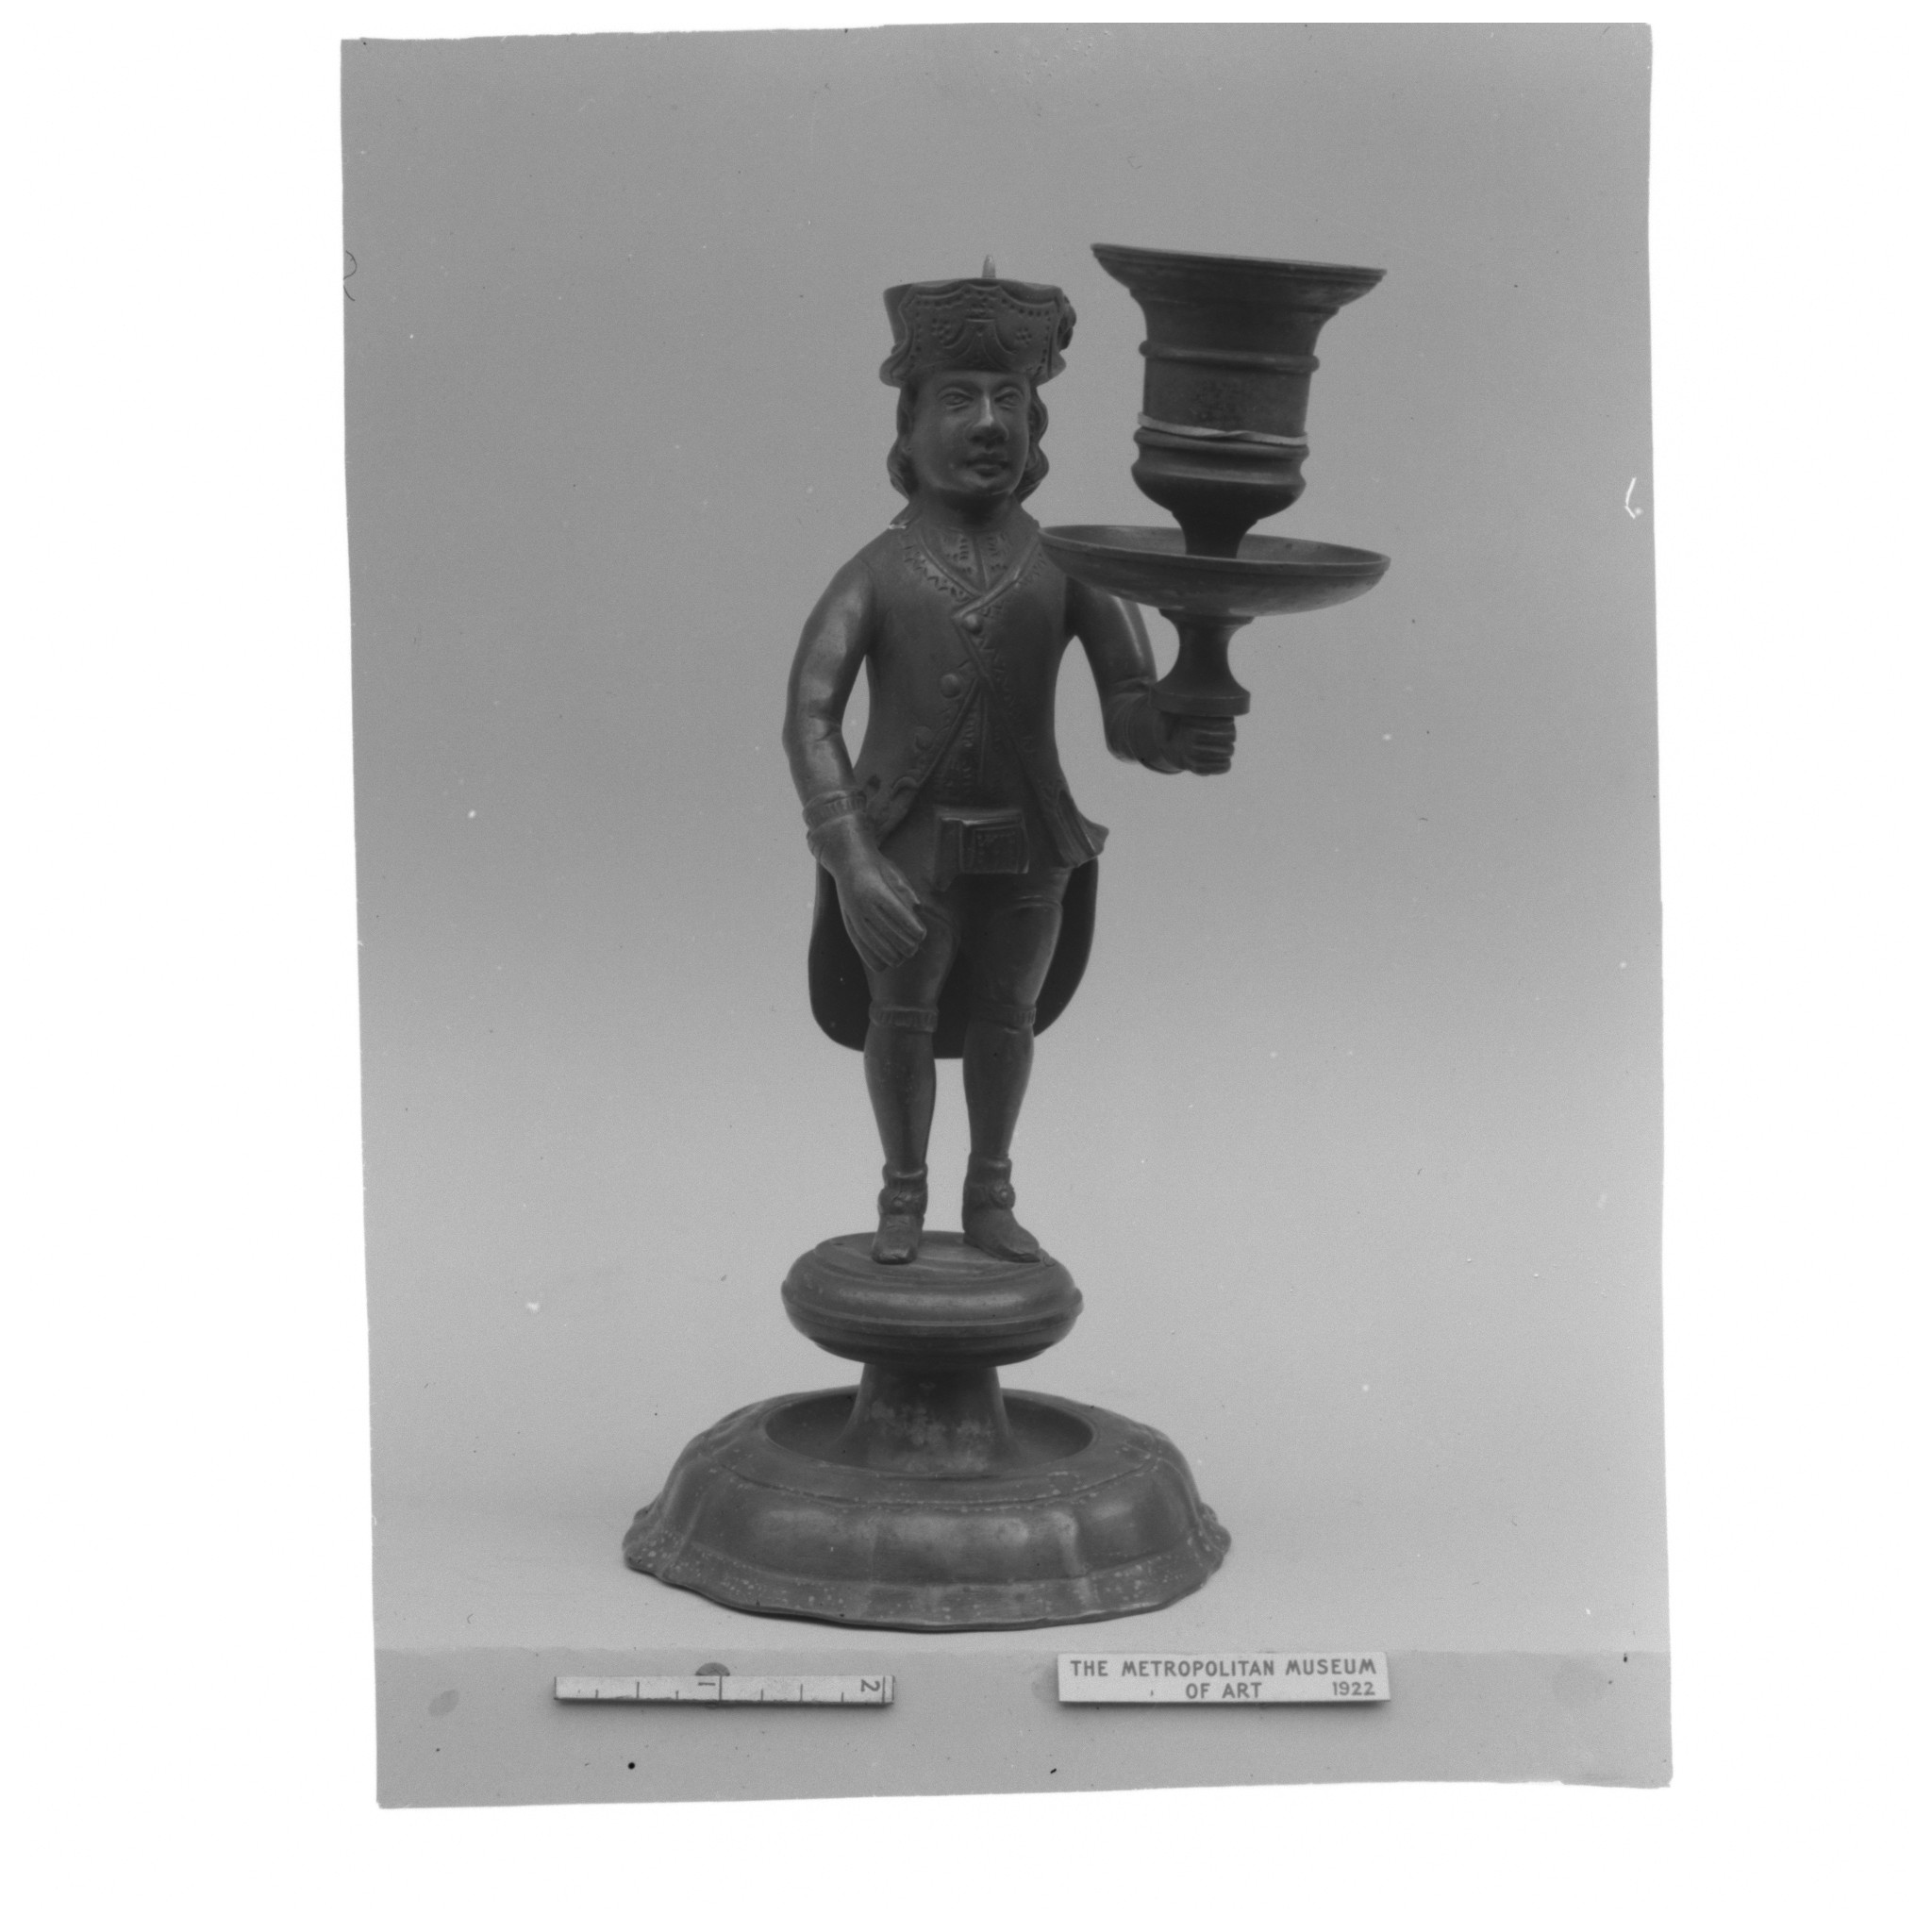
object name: candlestick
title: Pair of candlesticks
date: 1701-1800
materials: brass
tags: men